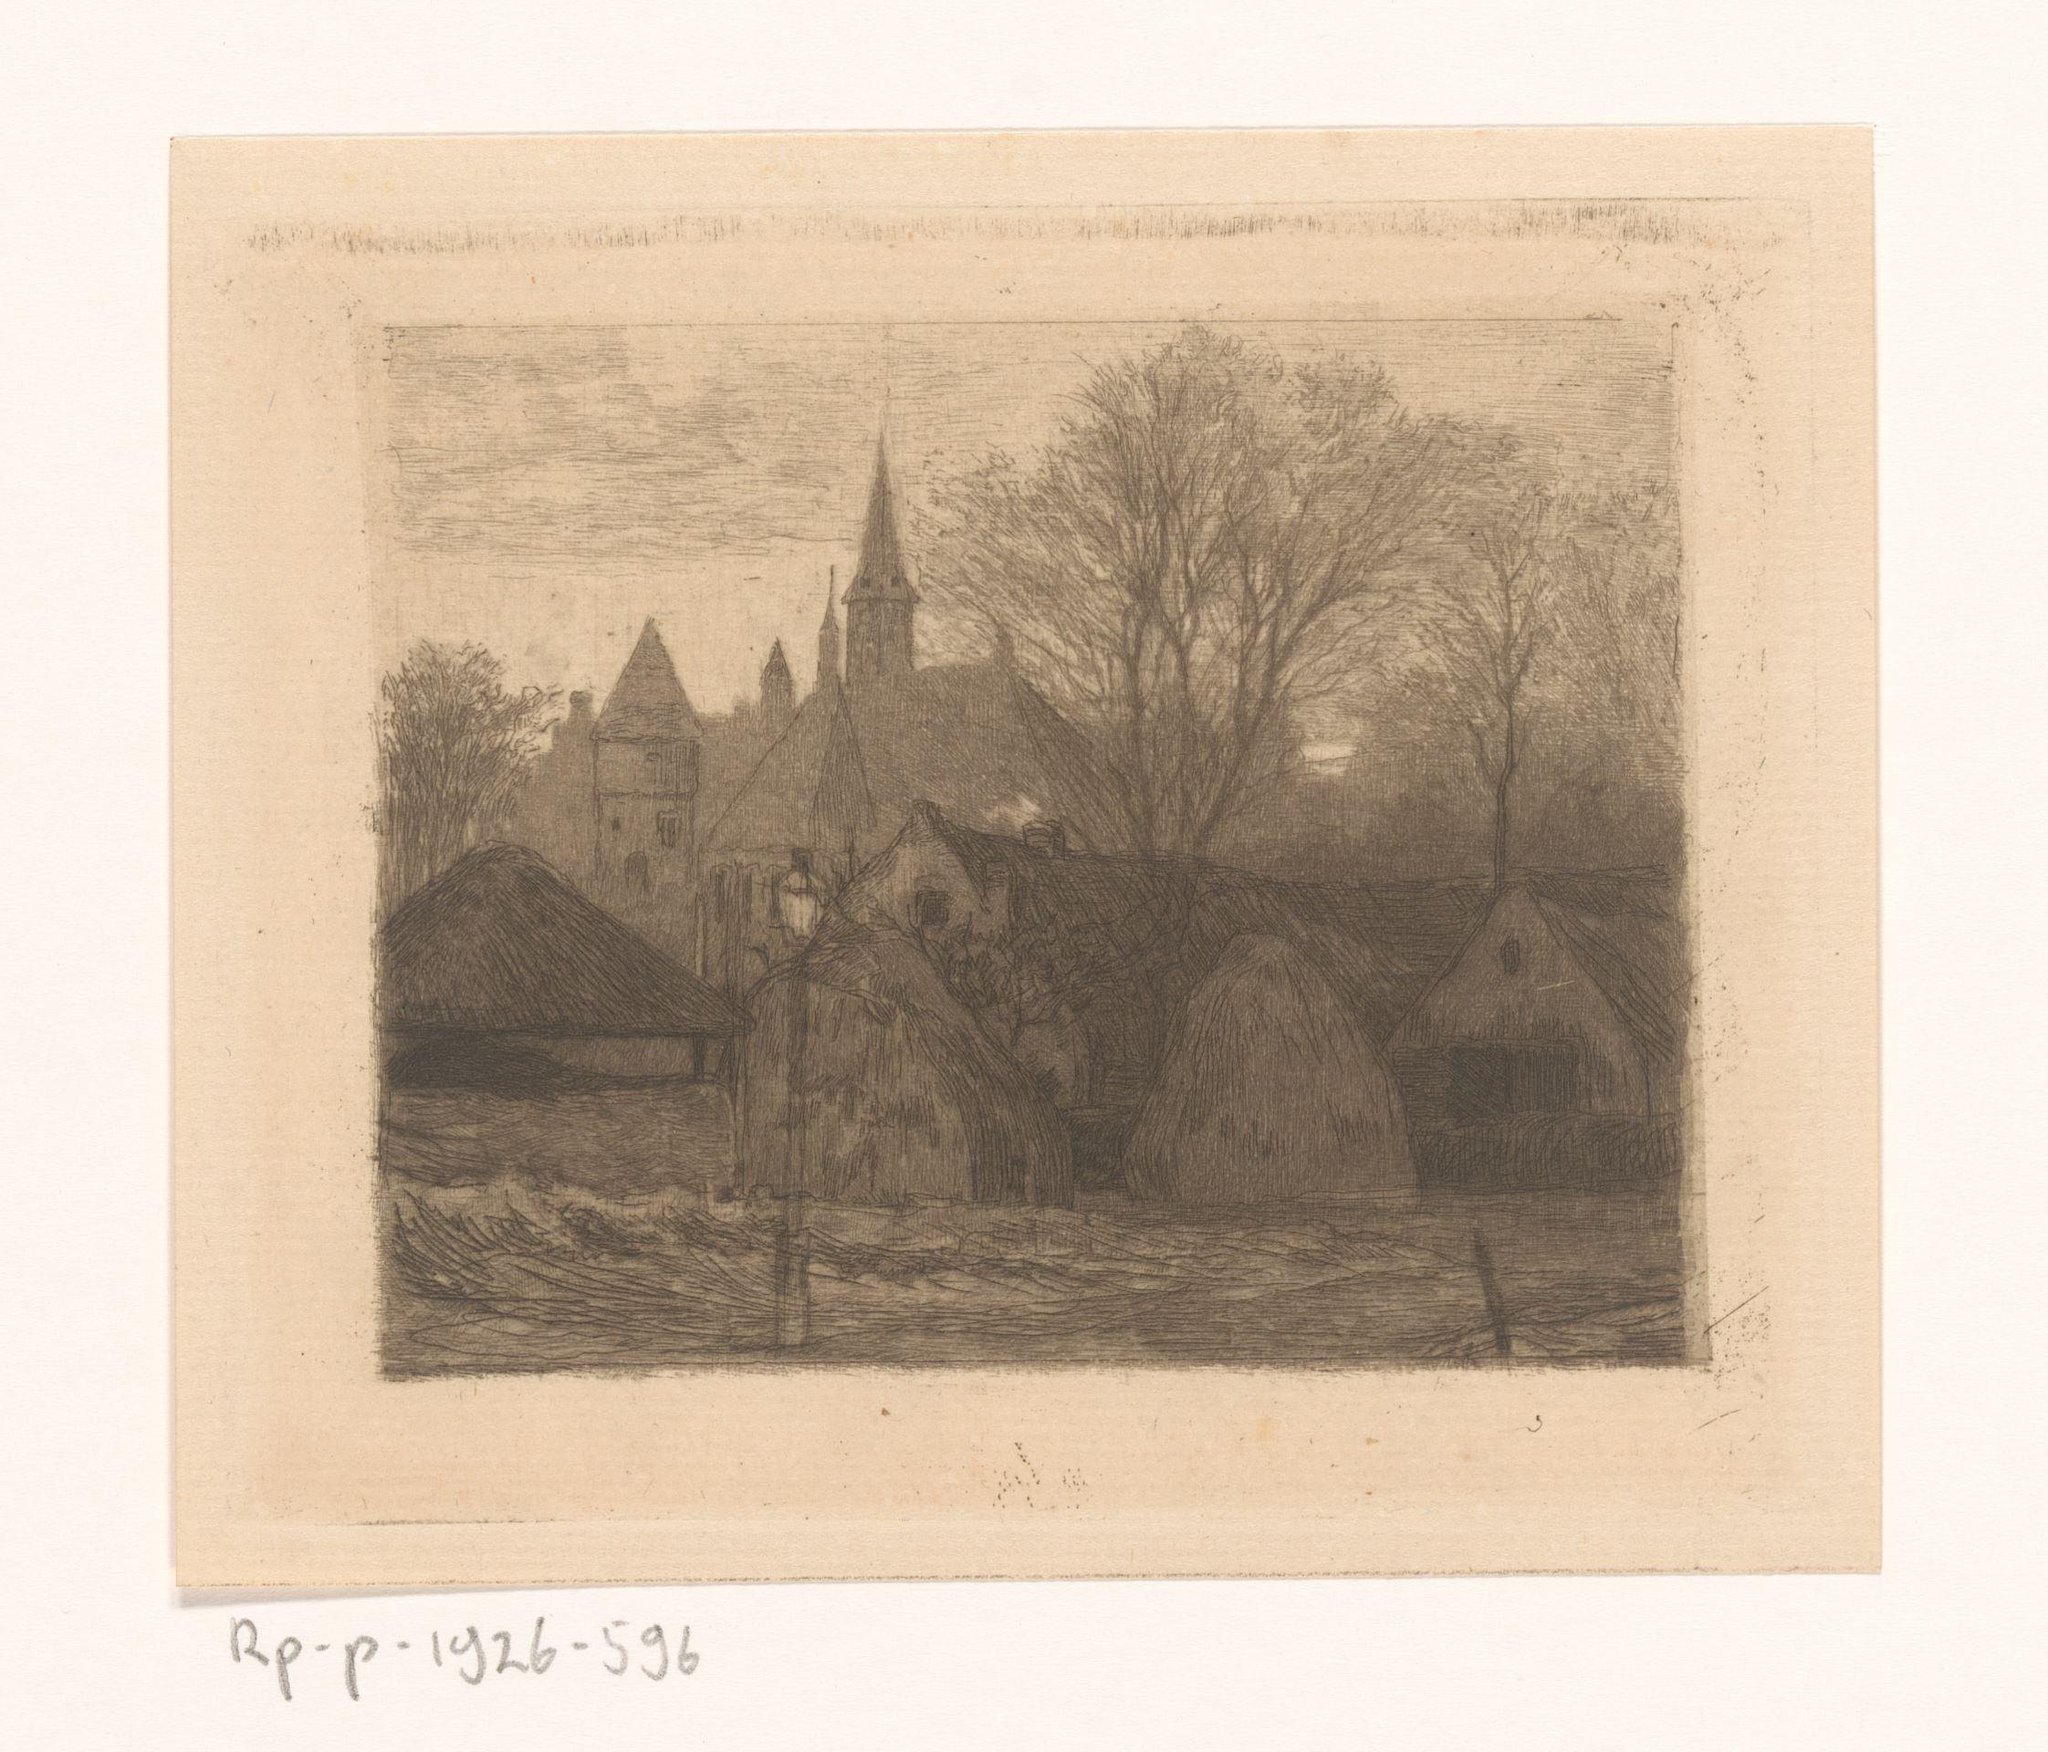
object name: print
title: Gezicht op Bussum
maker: jan veth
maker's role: designer, draughtsman, painter, print maker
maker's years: 1864-1925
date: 1889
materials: paper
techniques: drypoint, etching, intaglio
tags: village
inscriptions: collector's mark: Lugt 2228